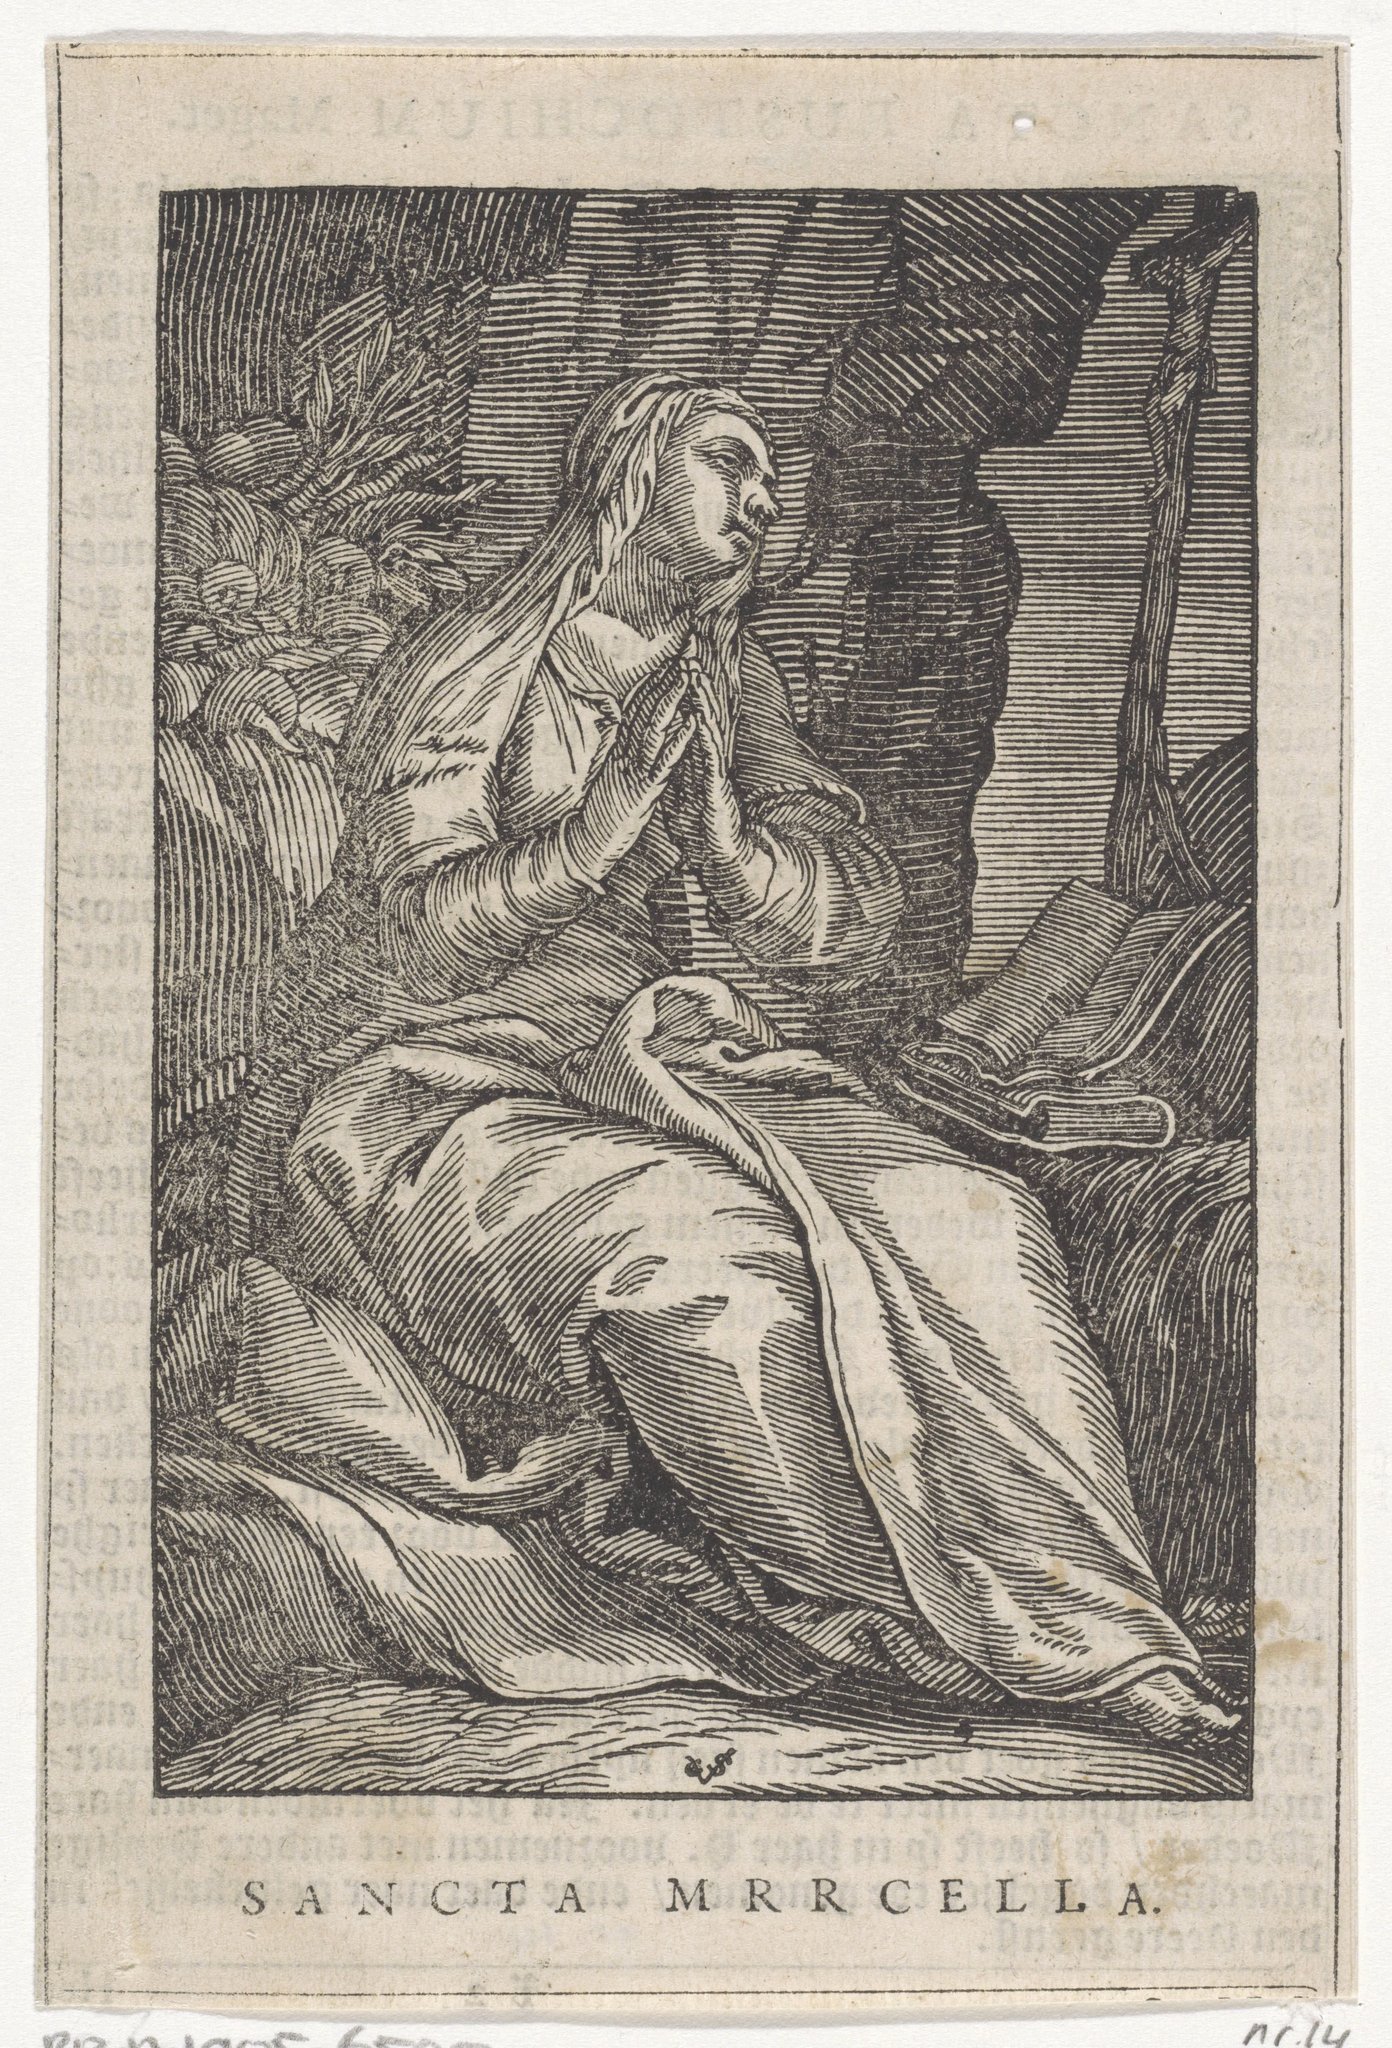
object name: book illustration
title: Sancta Marcella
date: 1644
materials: paper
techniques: letterpress printing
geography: amsterdam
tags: anchorite, hermit, female saints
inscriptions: collector's mark: Lugt 2228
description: Prent uit: Rosweyde, Heribert. 'tBosch der eremyten ende eremitinnen, van Aegypten ende Palestinen. Amsterdam: Pieter Jacobsz. Paets, 1644.